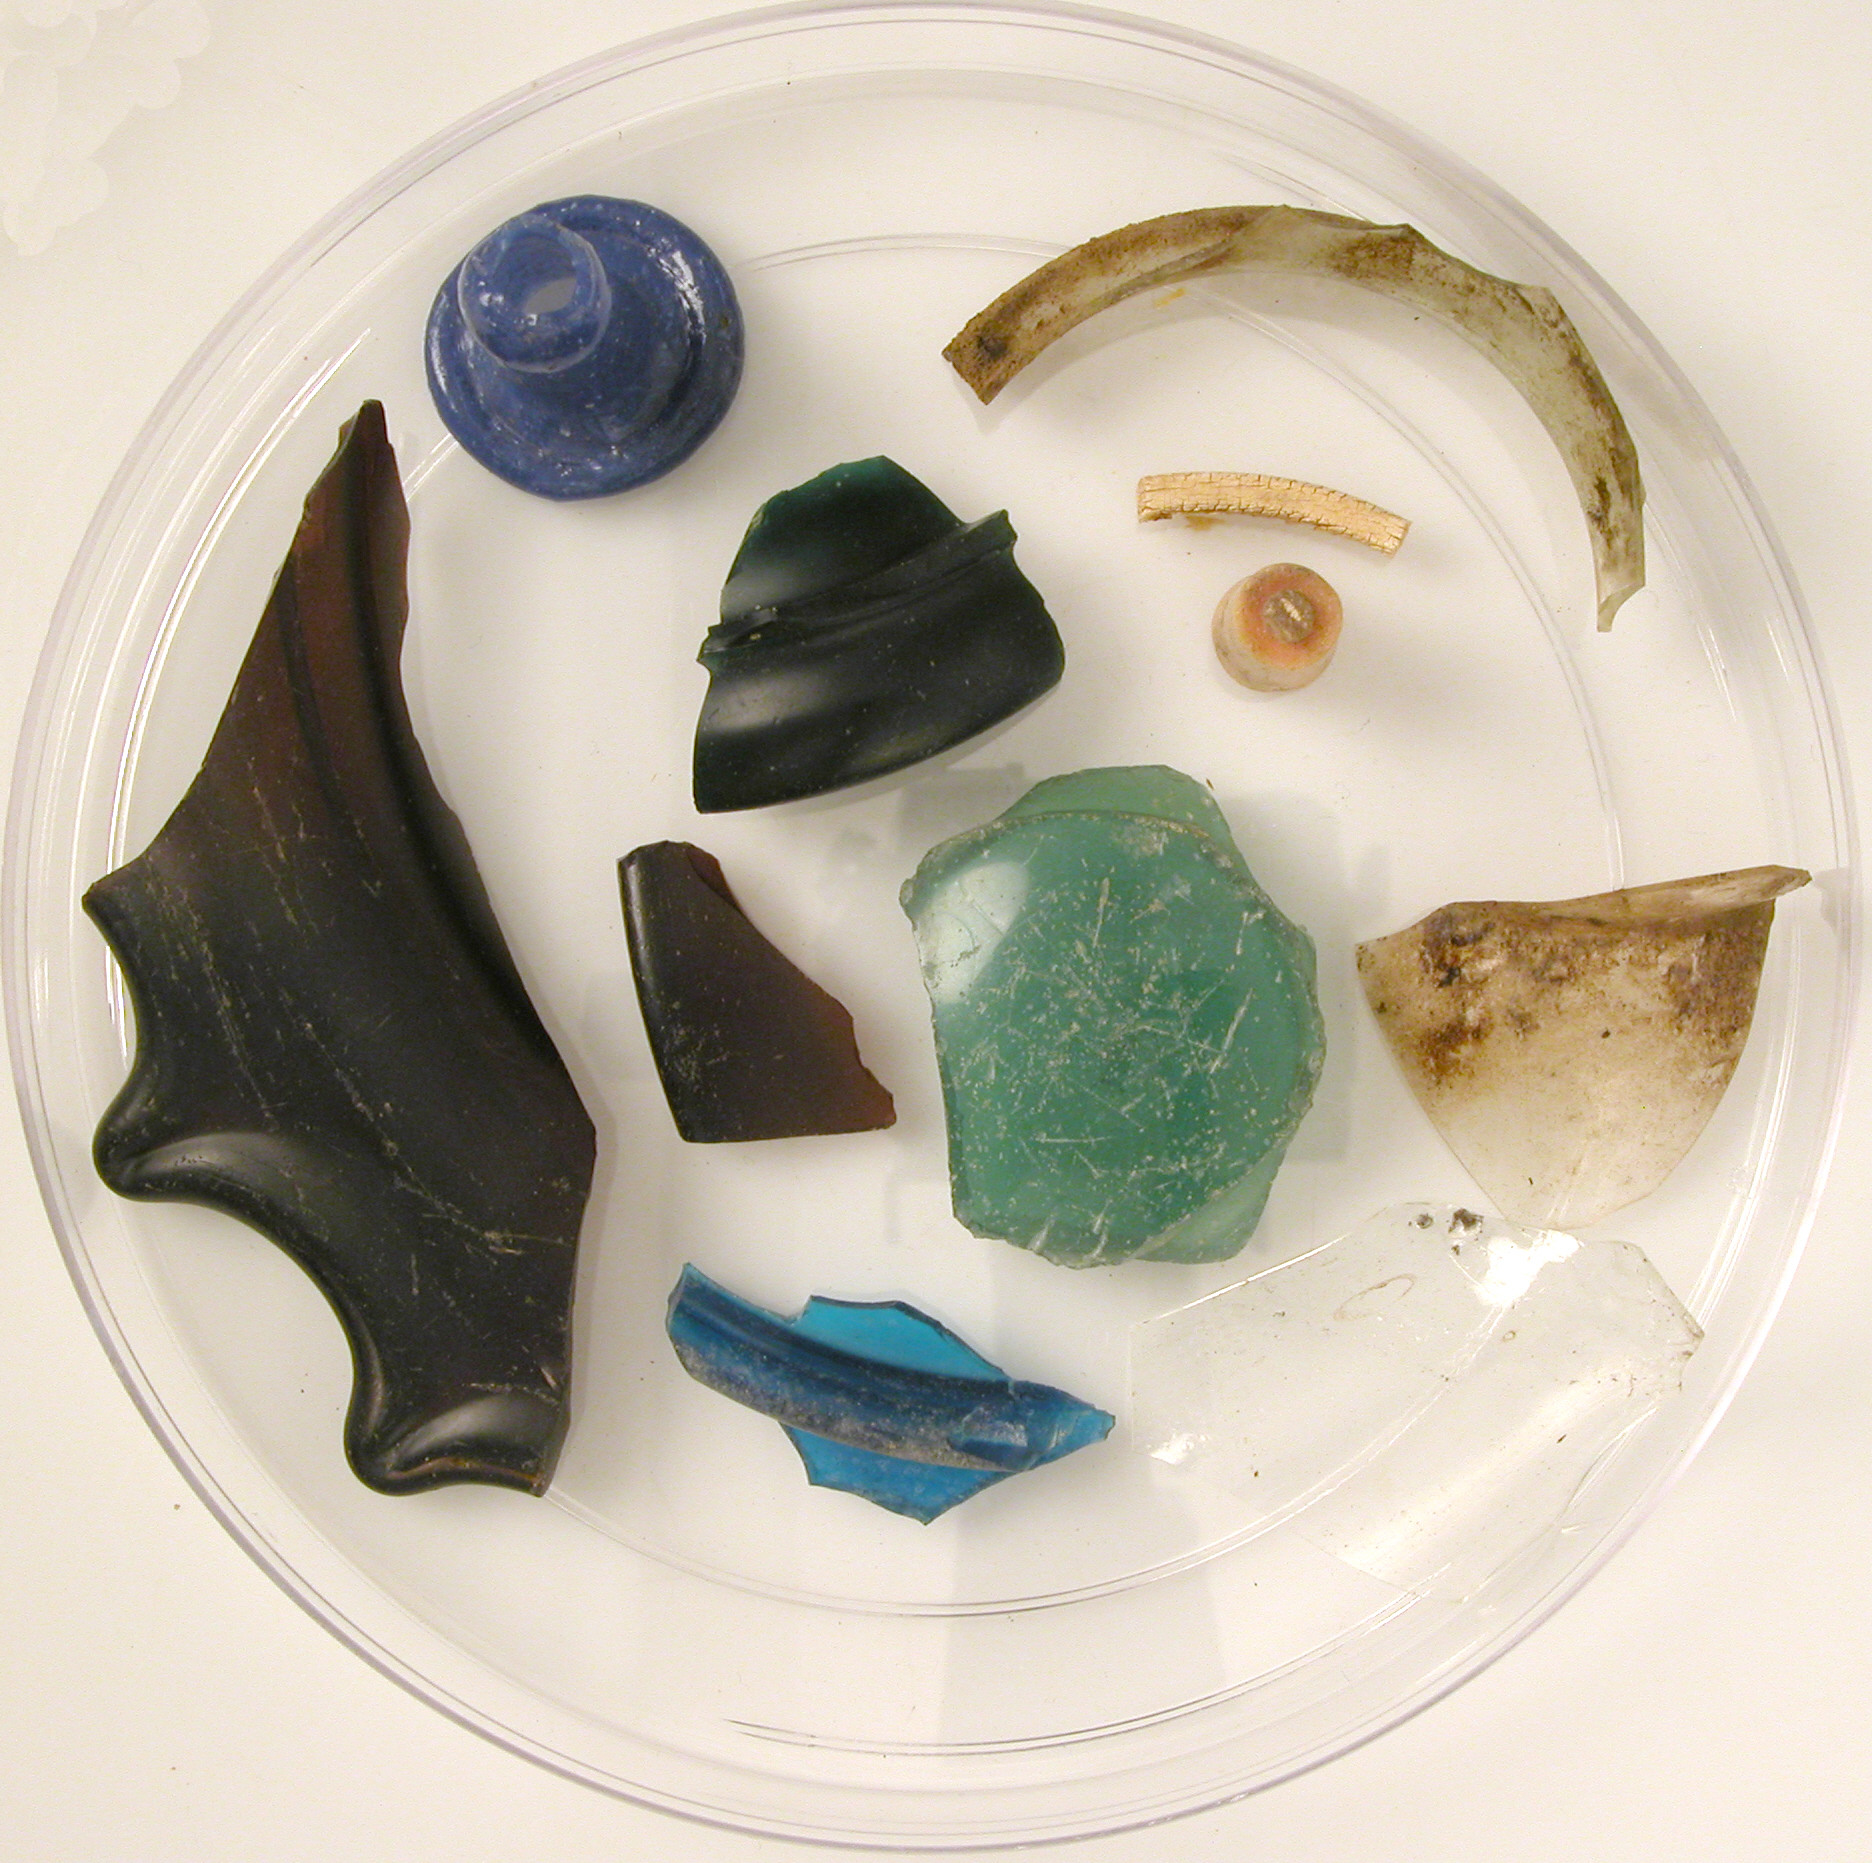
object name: fragment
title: Glass Fragments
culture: coptic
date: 301-700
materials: glass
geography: egypt